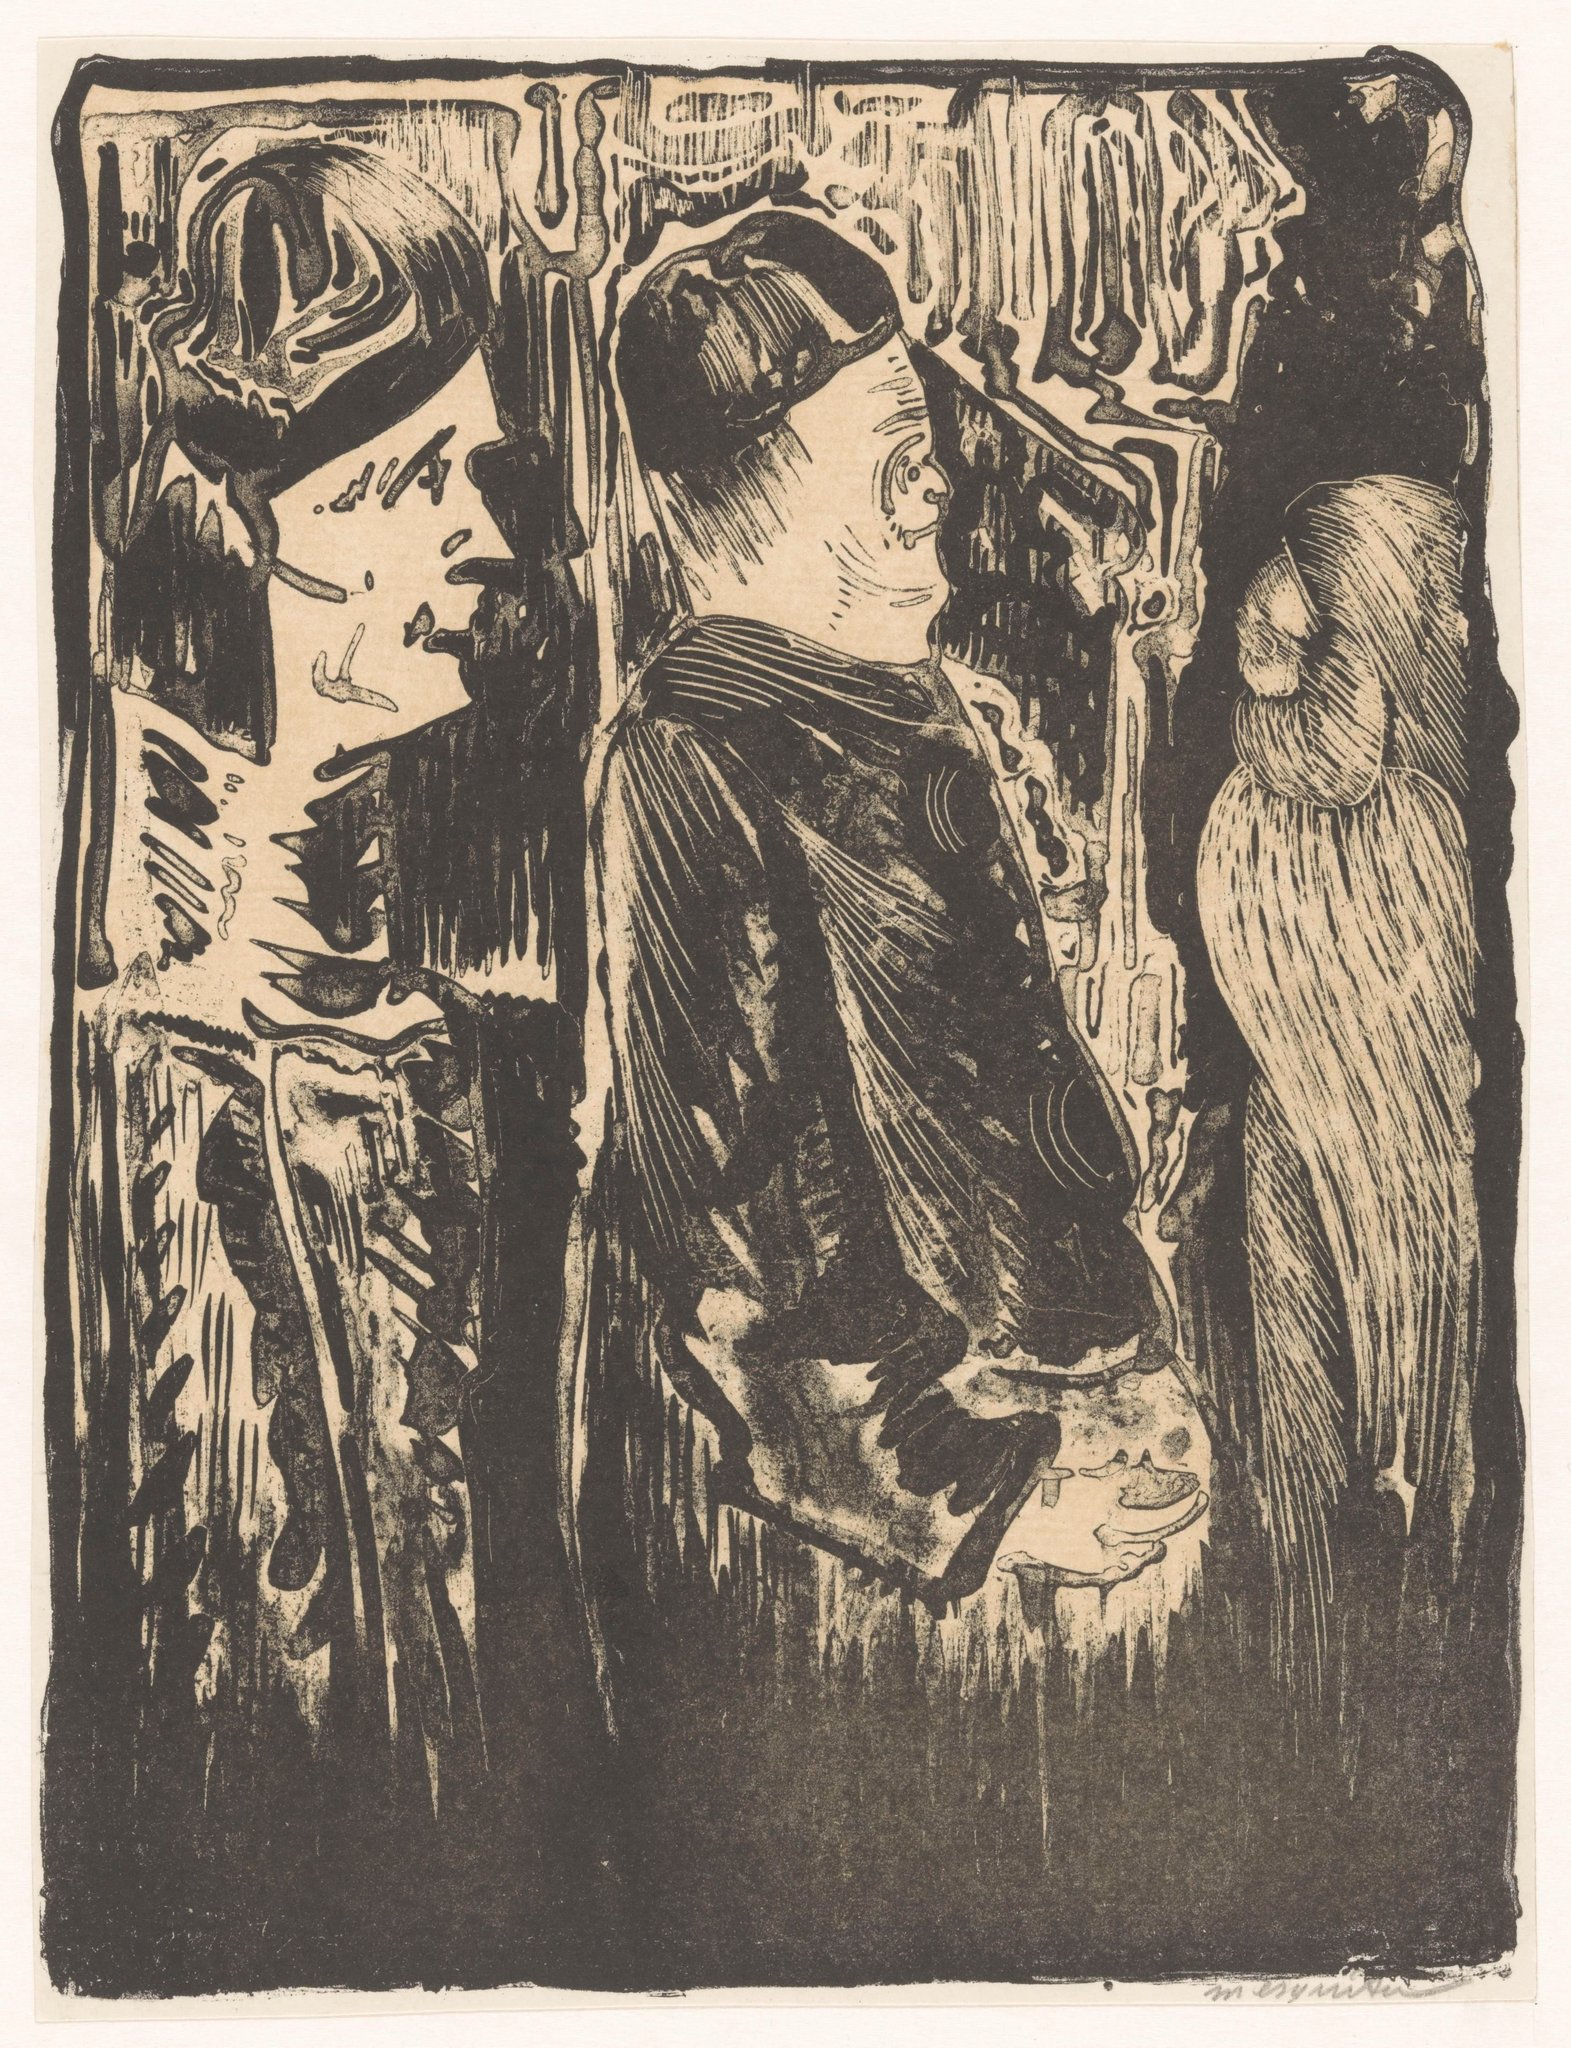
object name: print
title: Fantasie: links twee figuren met mutsen op naar rechts, rechts een ingekraste verschijning met verenkleed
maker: samuel jessurun de mesquita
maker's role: draughtsman, print maker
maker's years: 1868-1944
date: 1919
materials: paper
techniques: lithograph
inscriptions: signature: ‘mesquita’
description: Links twee figuren met mutsen op naar rechts, rechts een ingekraste verschijning met verenkleed.